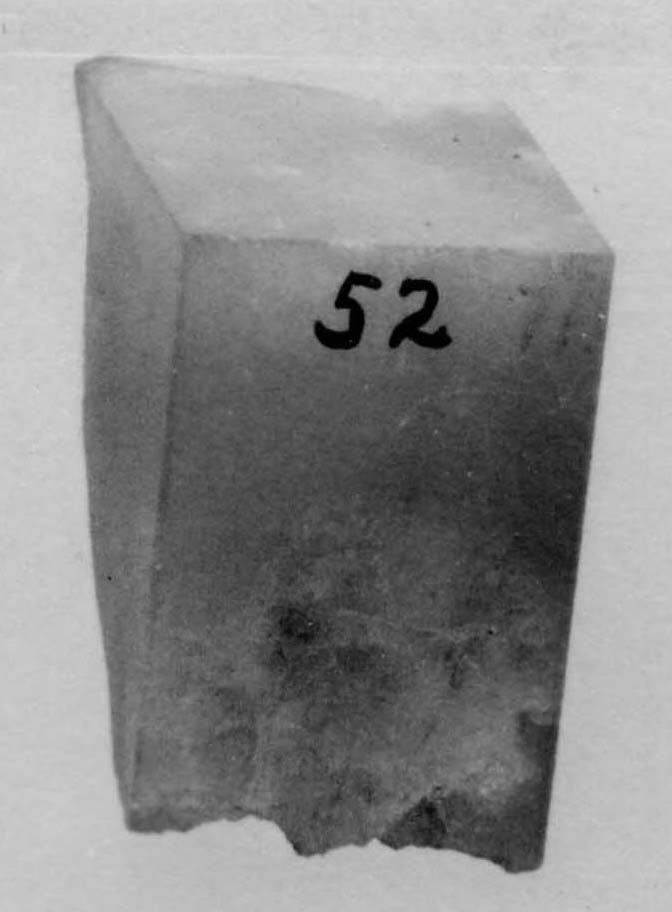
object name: fragment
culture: tibetan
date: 1902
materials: jade